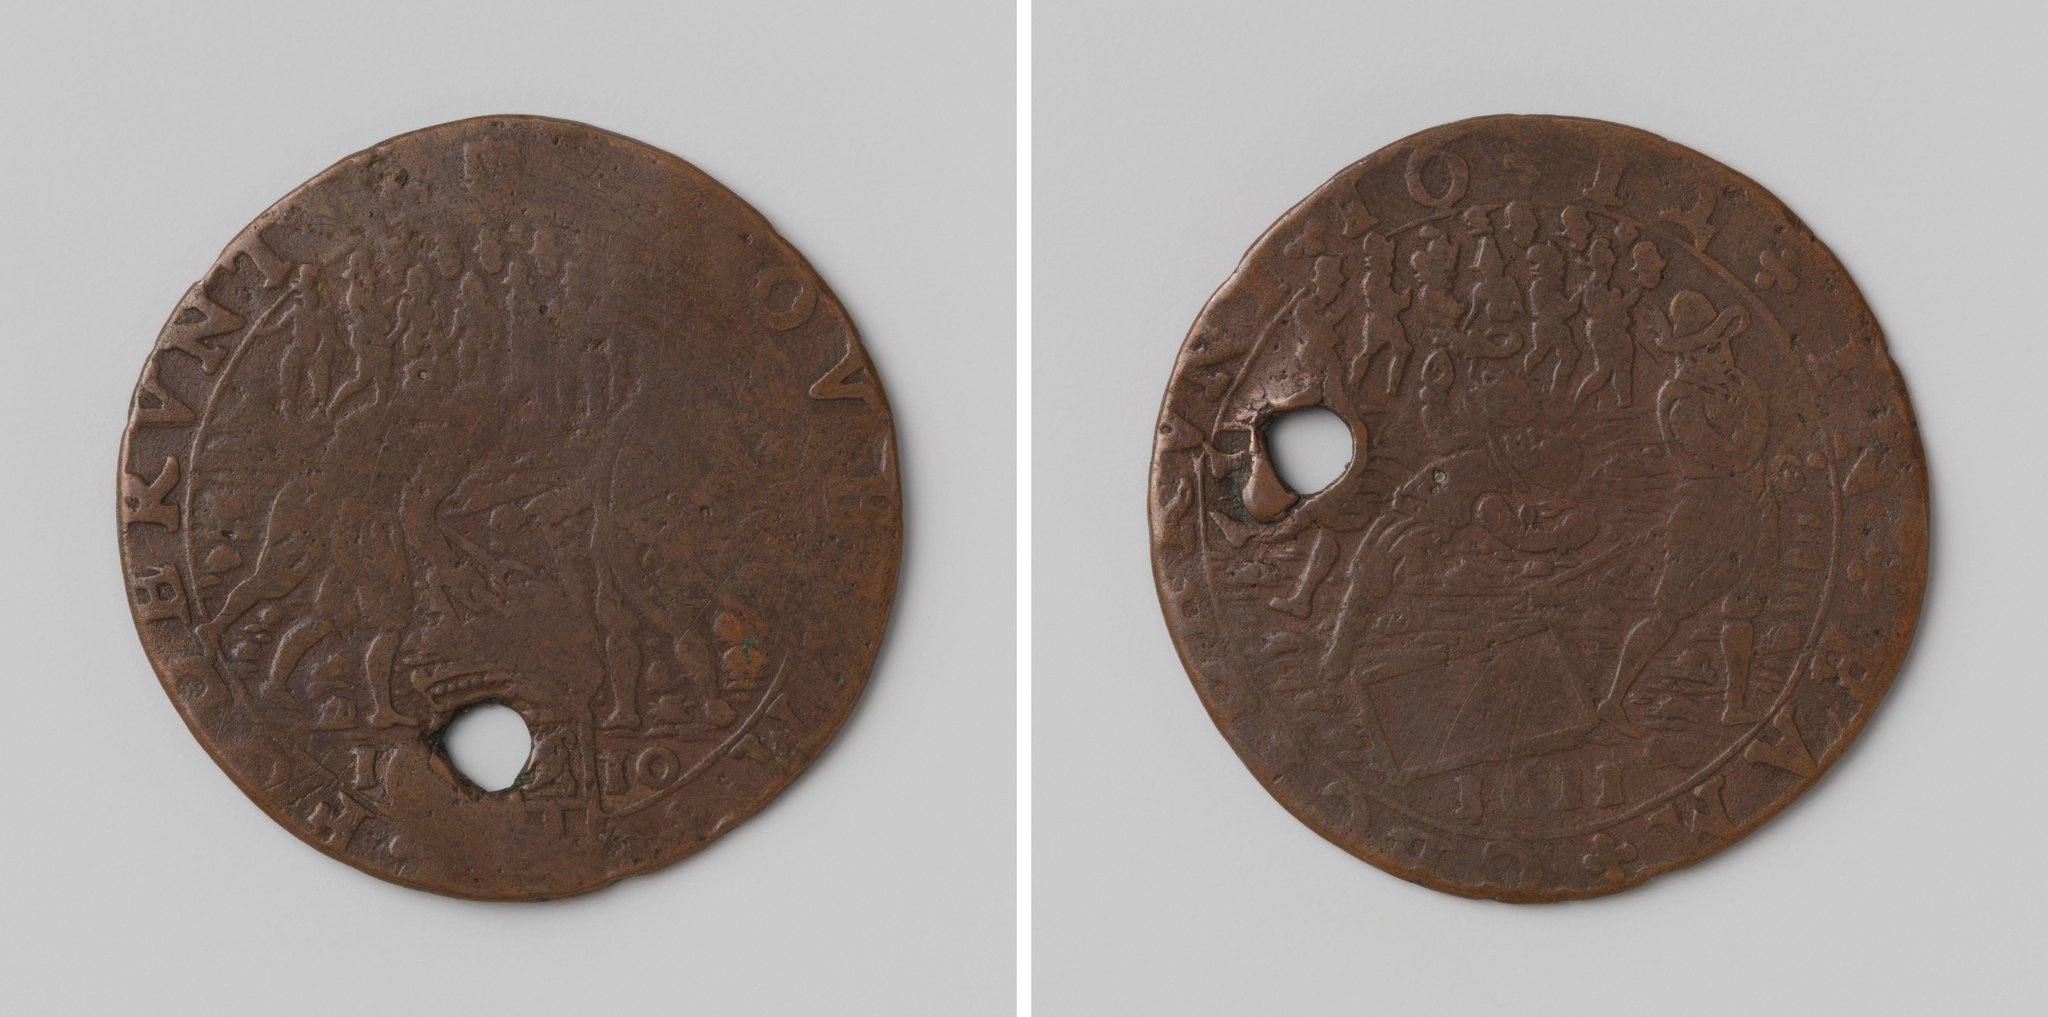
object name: jeton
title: Oproer te Utrecht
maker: Anonymous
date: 1612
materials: copper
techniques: striking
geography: utrecht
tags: dirk kanter, hendrik van helsding, staten van utrecht, eemland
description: Koperen penning met gat erin. Voorzijde: op aanraden van een Spanjaard graven twee mannen, voorstellende Dirk Kanter en Hendrik van Helsding, een kuil; daarom heen groot aantal toeschouwers boven gekroond wapenschild tussen jaartal binnen omschrift. Keerzijde: de beide mannen vallen in hun eigen kuil, terwijl de Spanjaard in zijn vuistje lacht en de toeschouwers afdruipen boven jaartal binnen omschrift